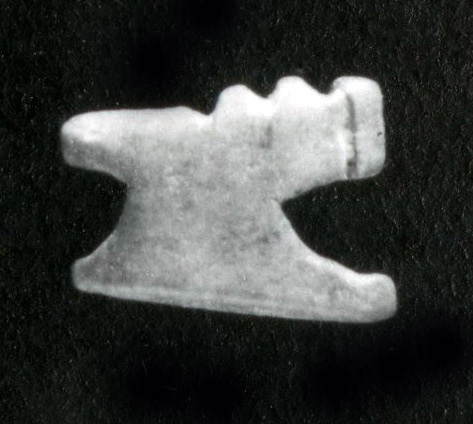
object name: amulet, lion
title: Lion amulet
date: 2110-2030 BCE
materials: ivory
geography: egypt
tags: lions